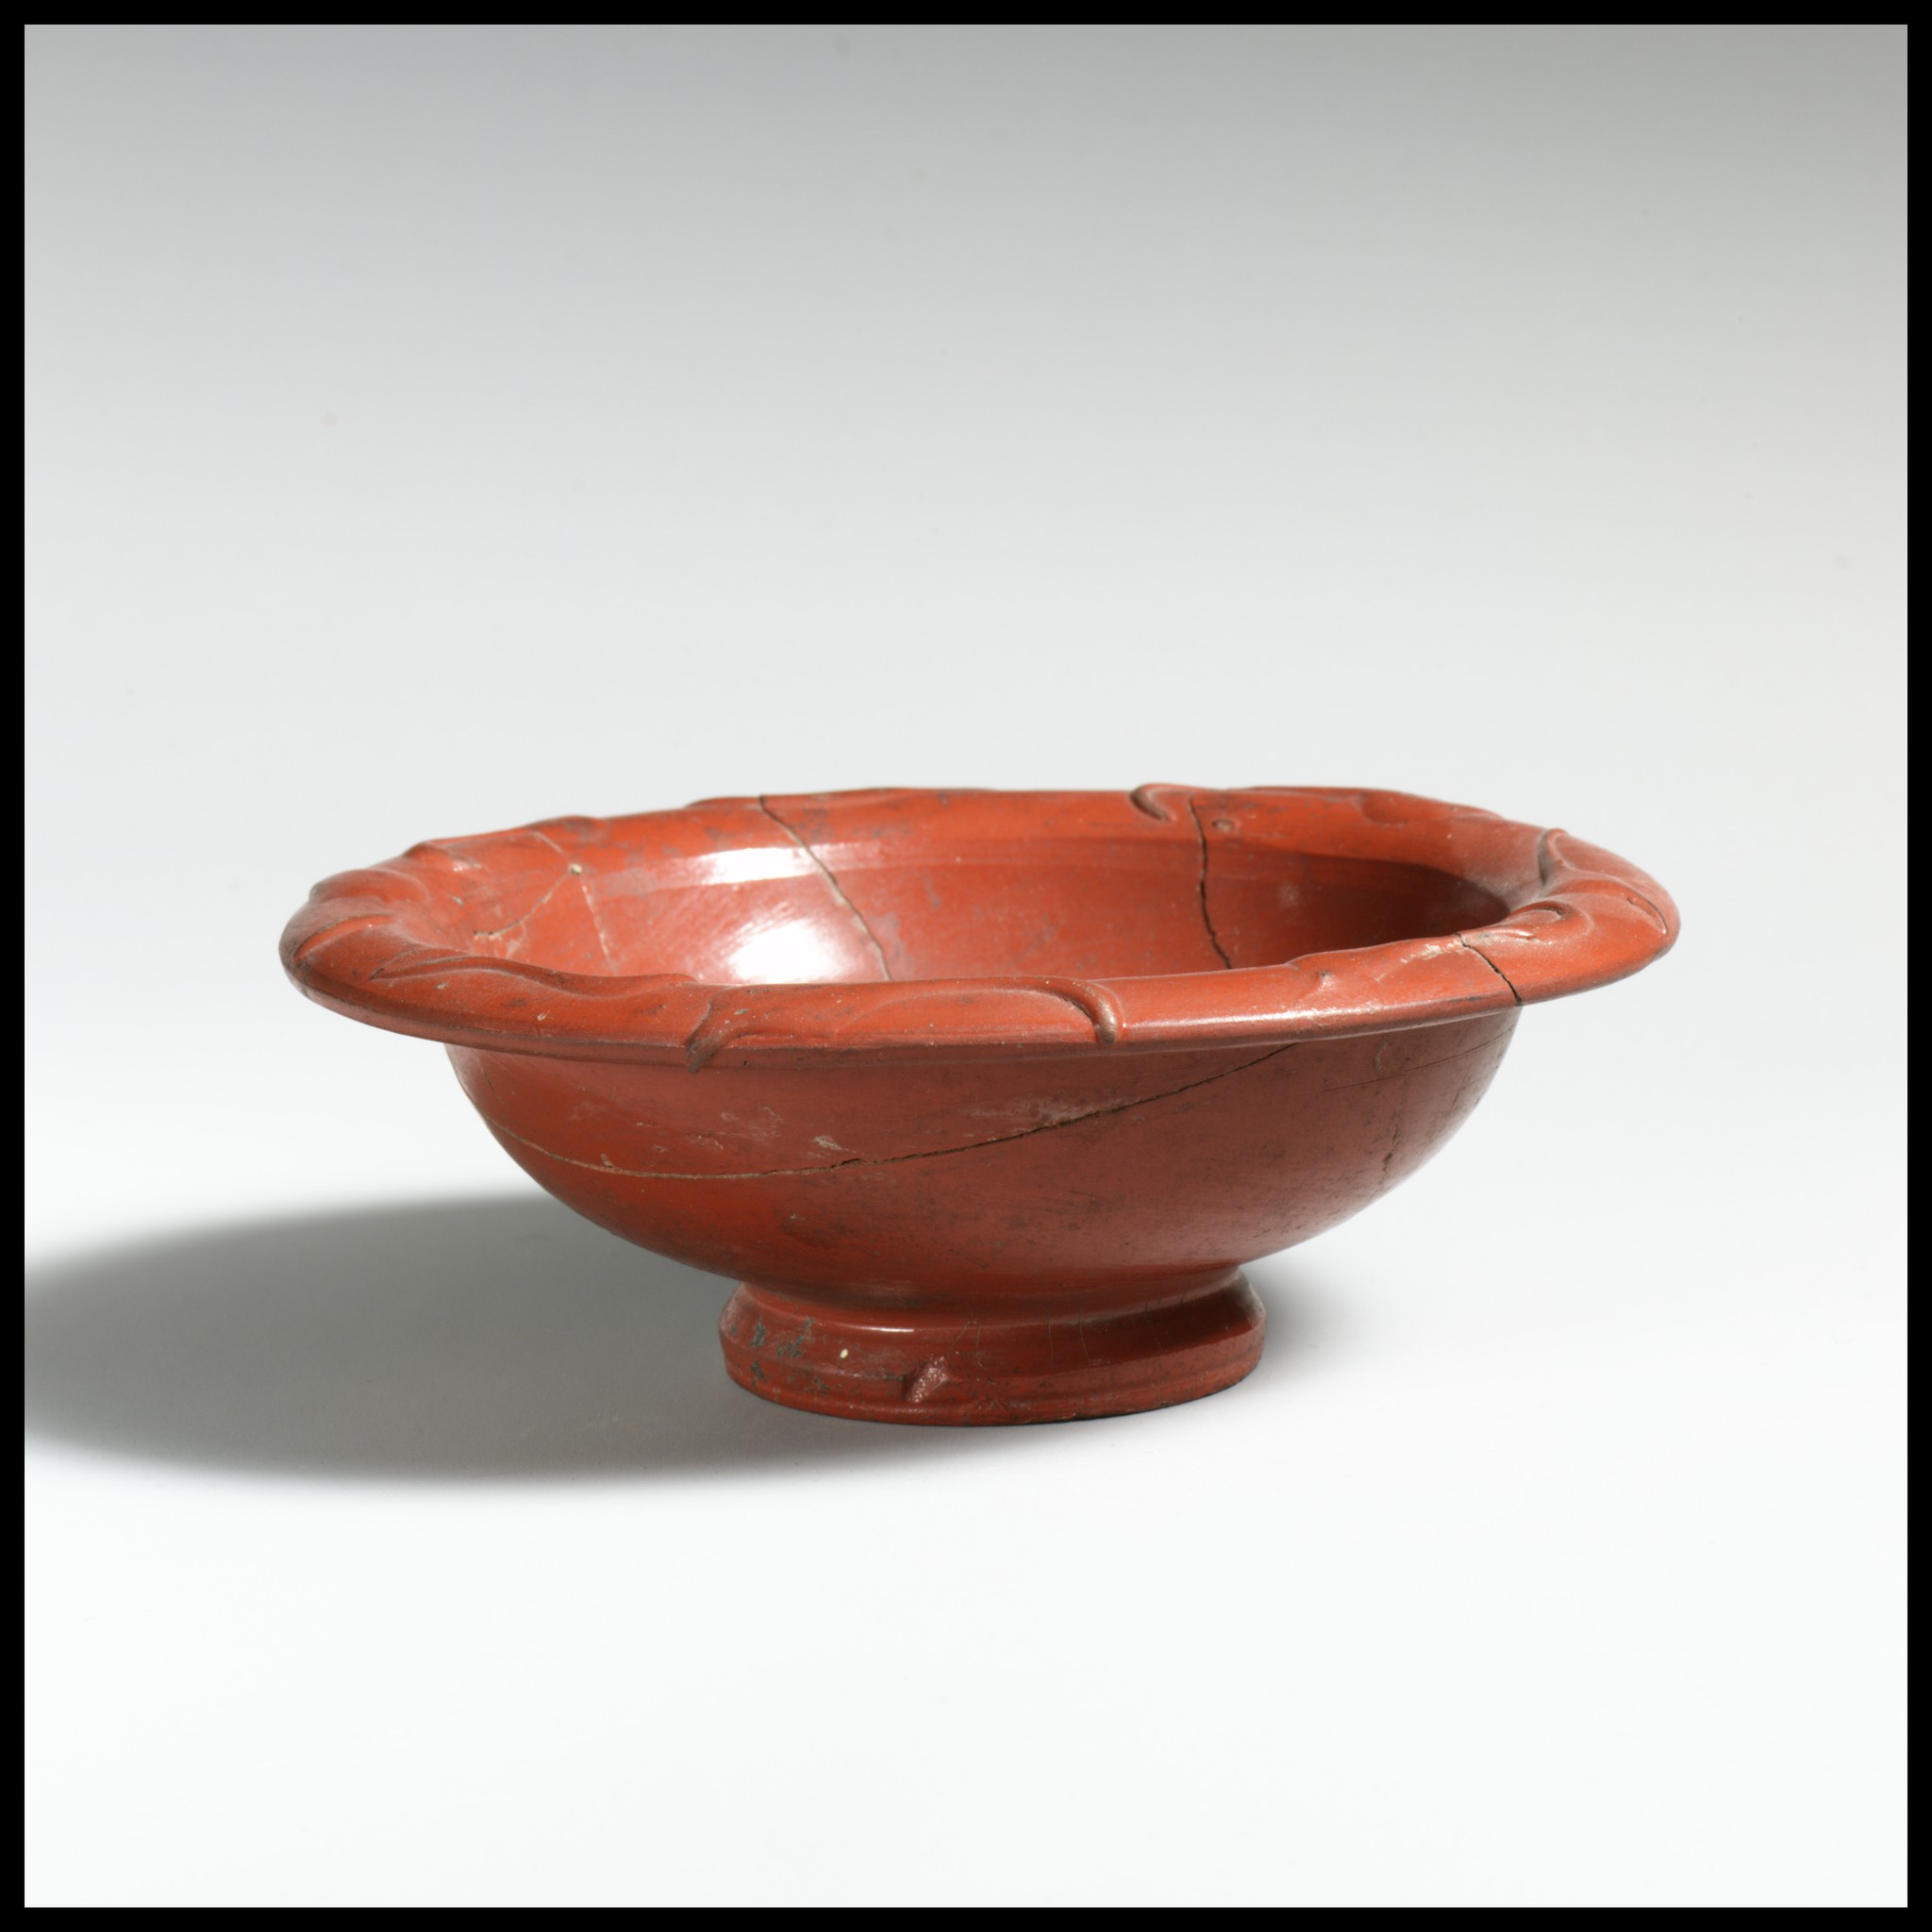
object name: plate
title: Terracotta bowl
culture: roman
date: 51-100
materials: terracotta